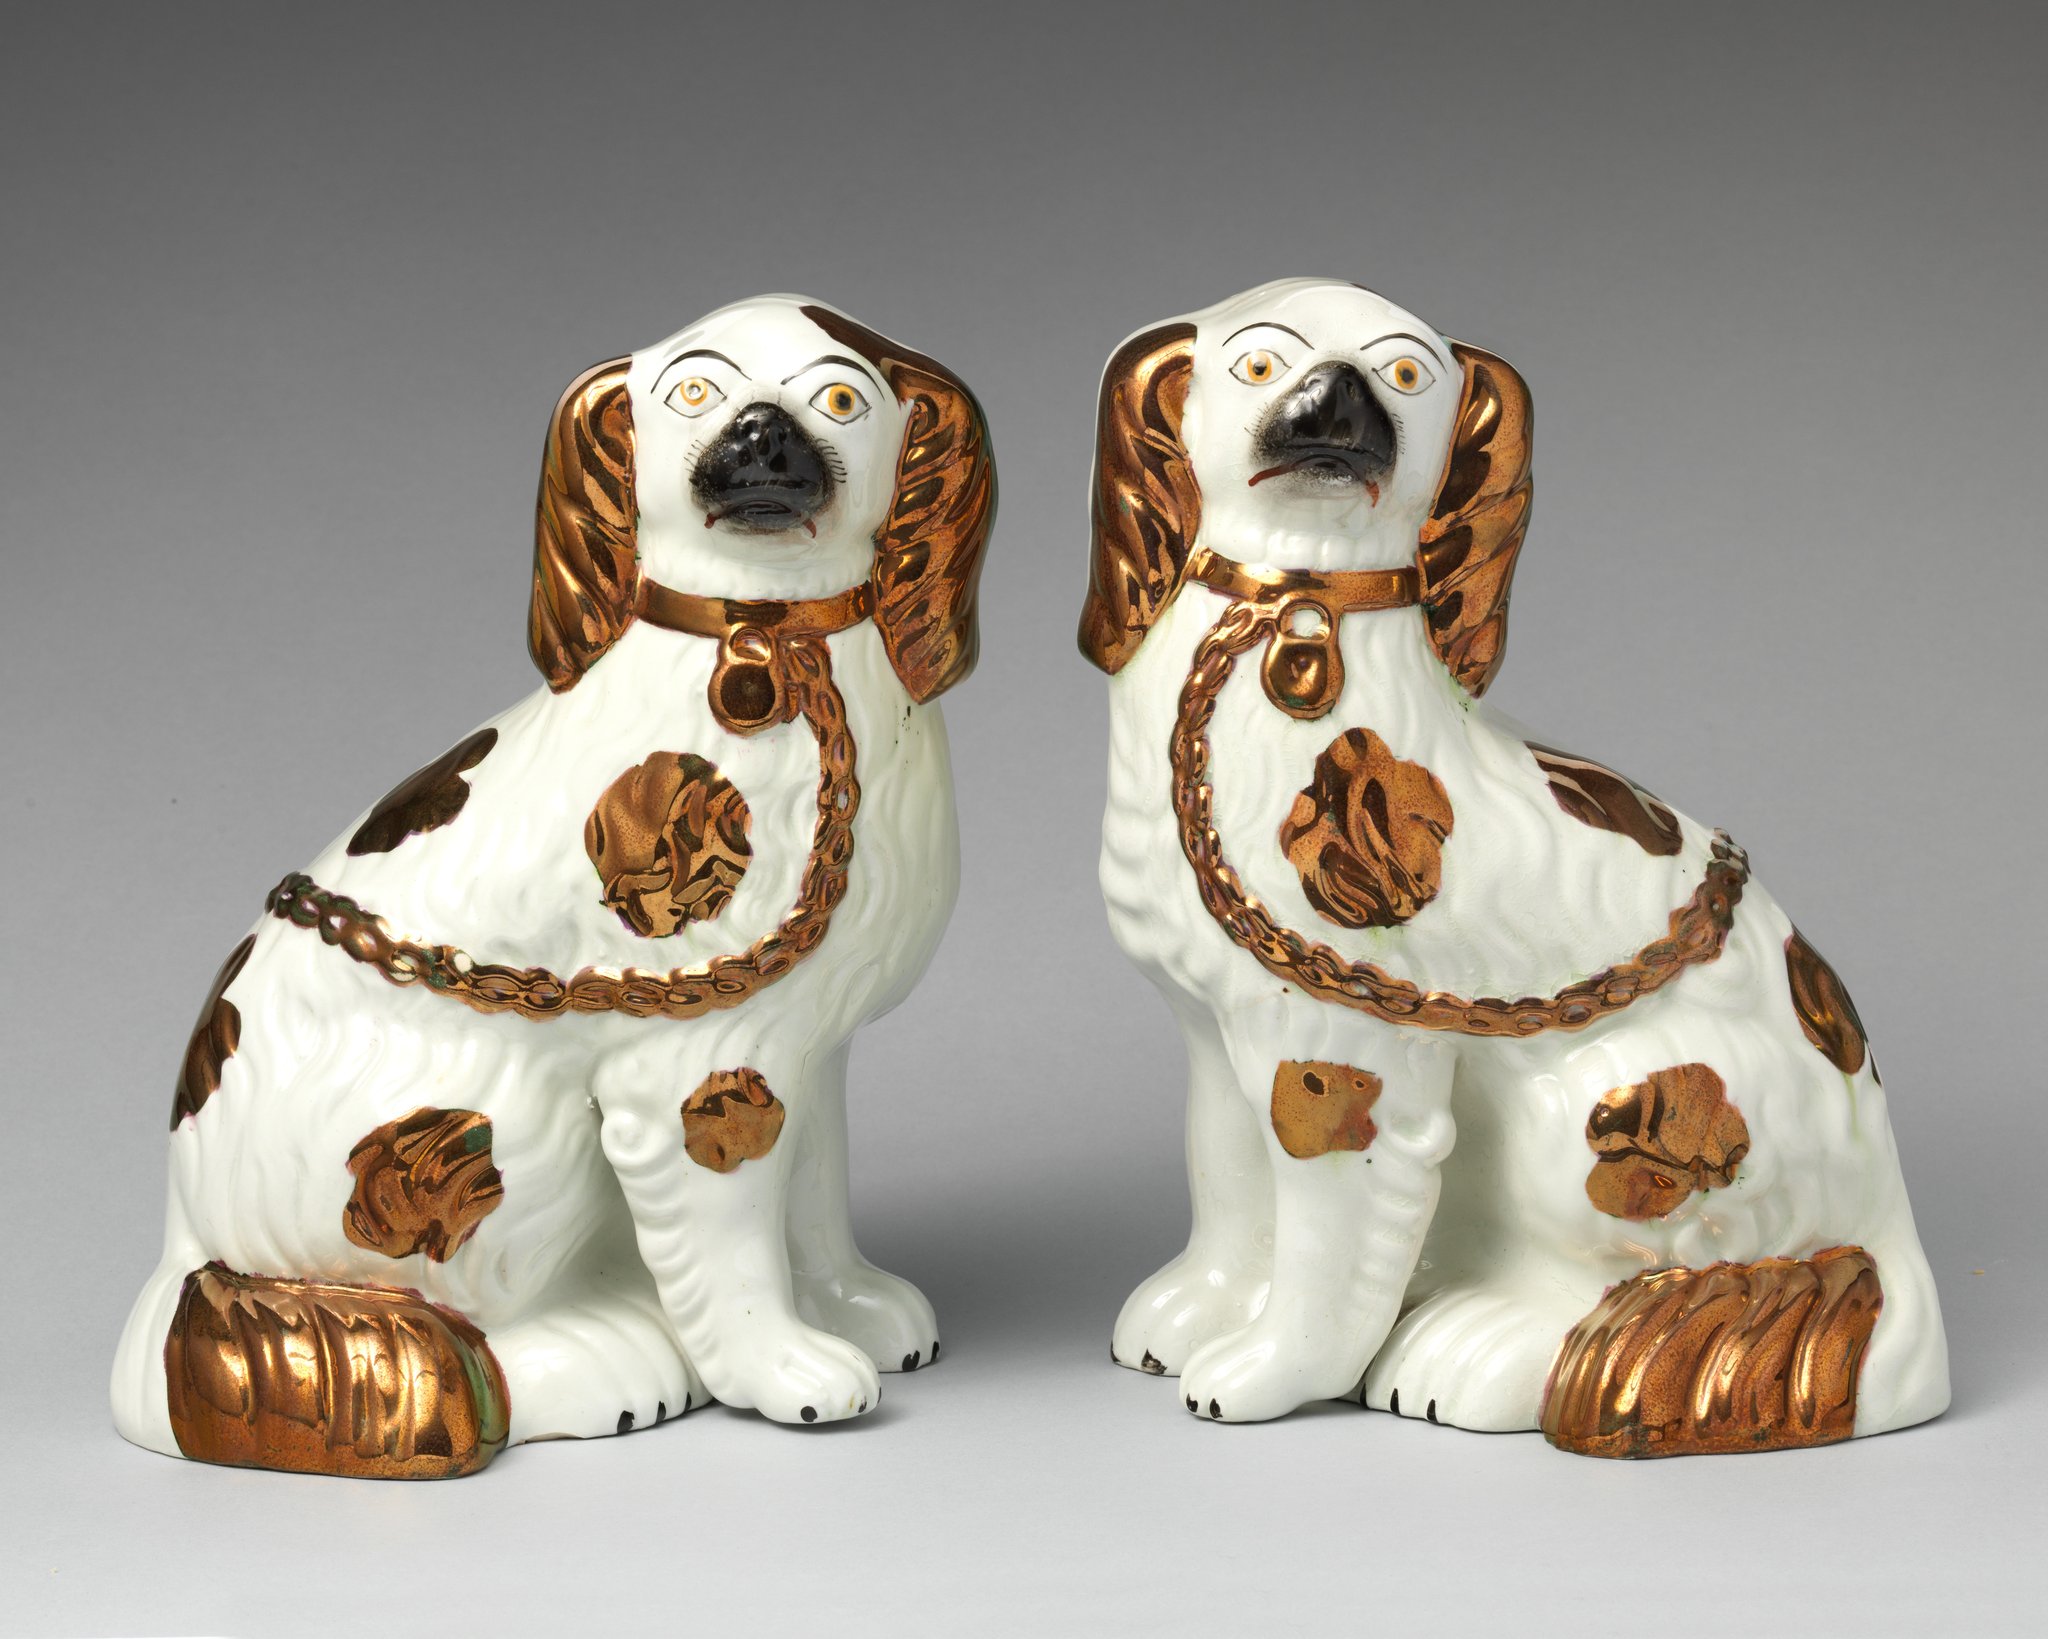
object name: figure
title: Pair of spaniels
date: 1830-1850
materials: copper, earthenware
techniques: glazing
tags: dogs